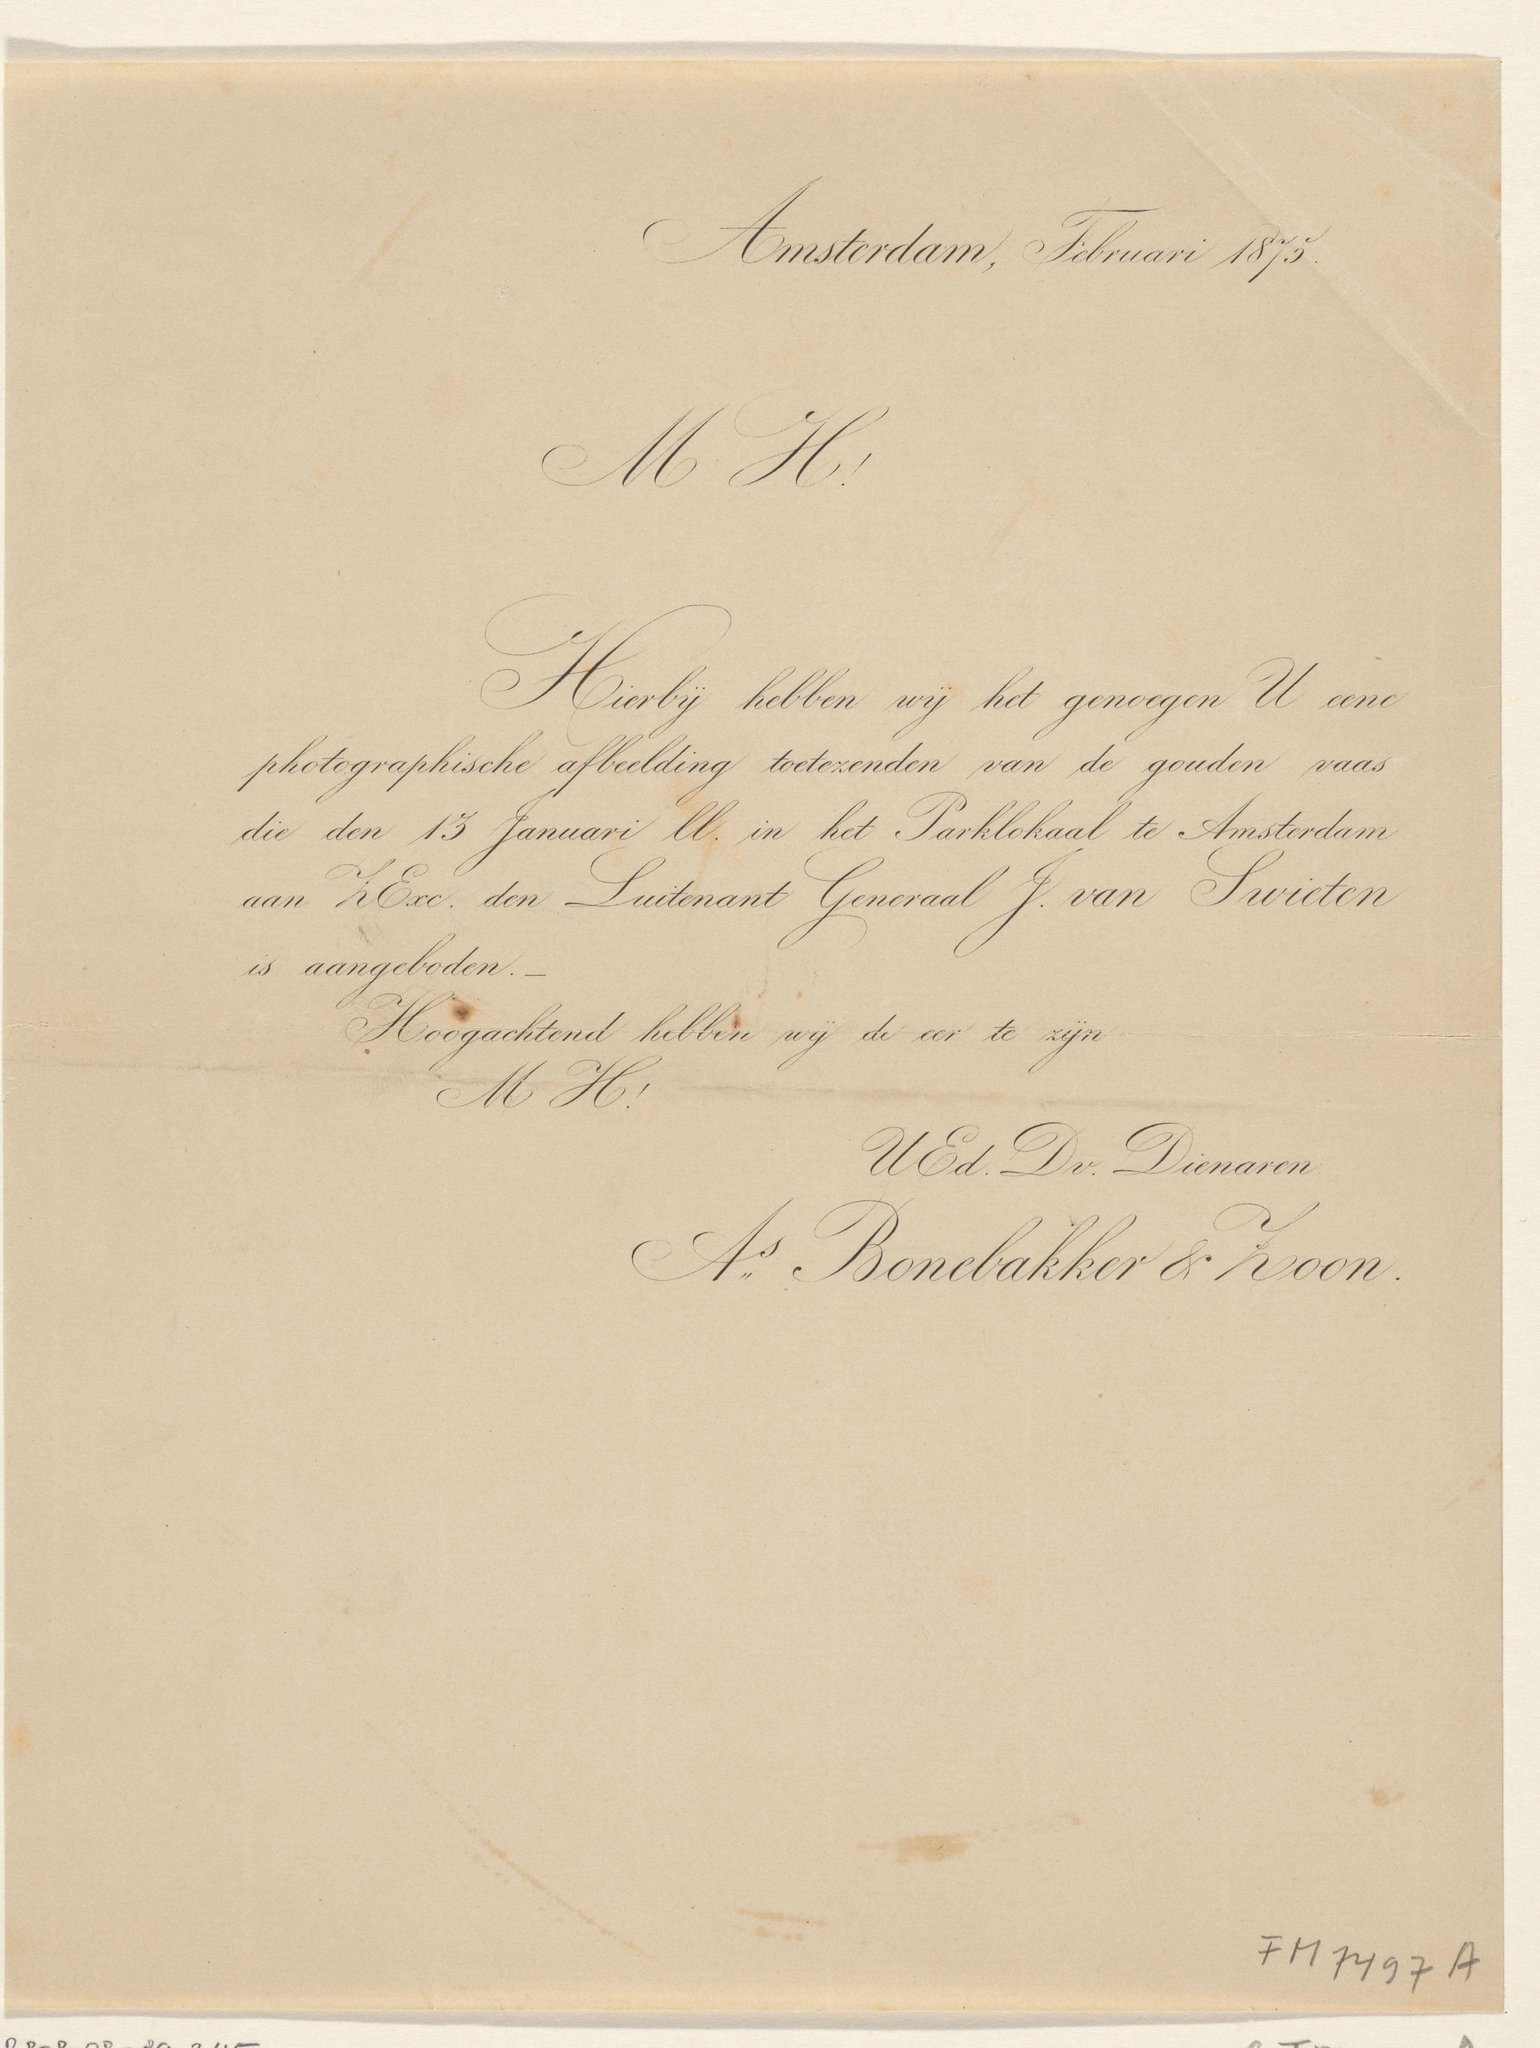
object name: letter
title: Brief over de foto van de vaas aangeboden aan luitenant-generaal Jan van Swieten, 1875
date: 1802-1875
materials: paper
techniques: lithograph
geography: amsterdam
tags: container of precious metal, amsterdam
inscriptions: collector's mark: Lugt 2228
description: Gedrukte brief van februari 1875 van de firma As. Bonebakker & Zoon over het toezenden van de foto van de door hen vervaardigde gouden vaas, als huldeblijk door enige aanzienlijke Amsterdammers aangeboden aan luitenant-generaal Jan van Swieten, te Amsterdam op 13 januari 1875. Zie ook de foto van de vaas.